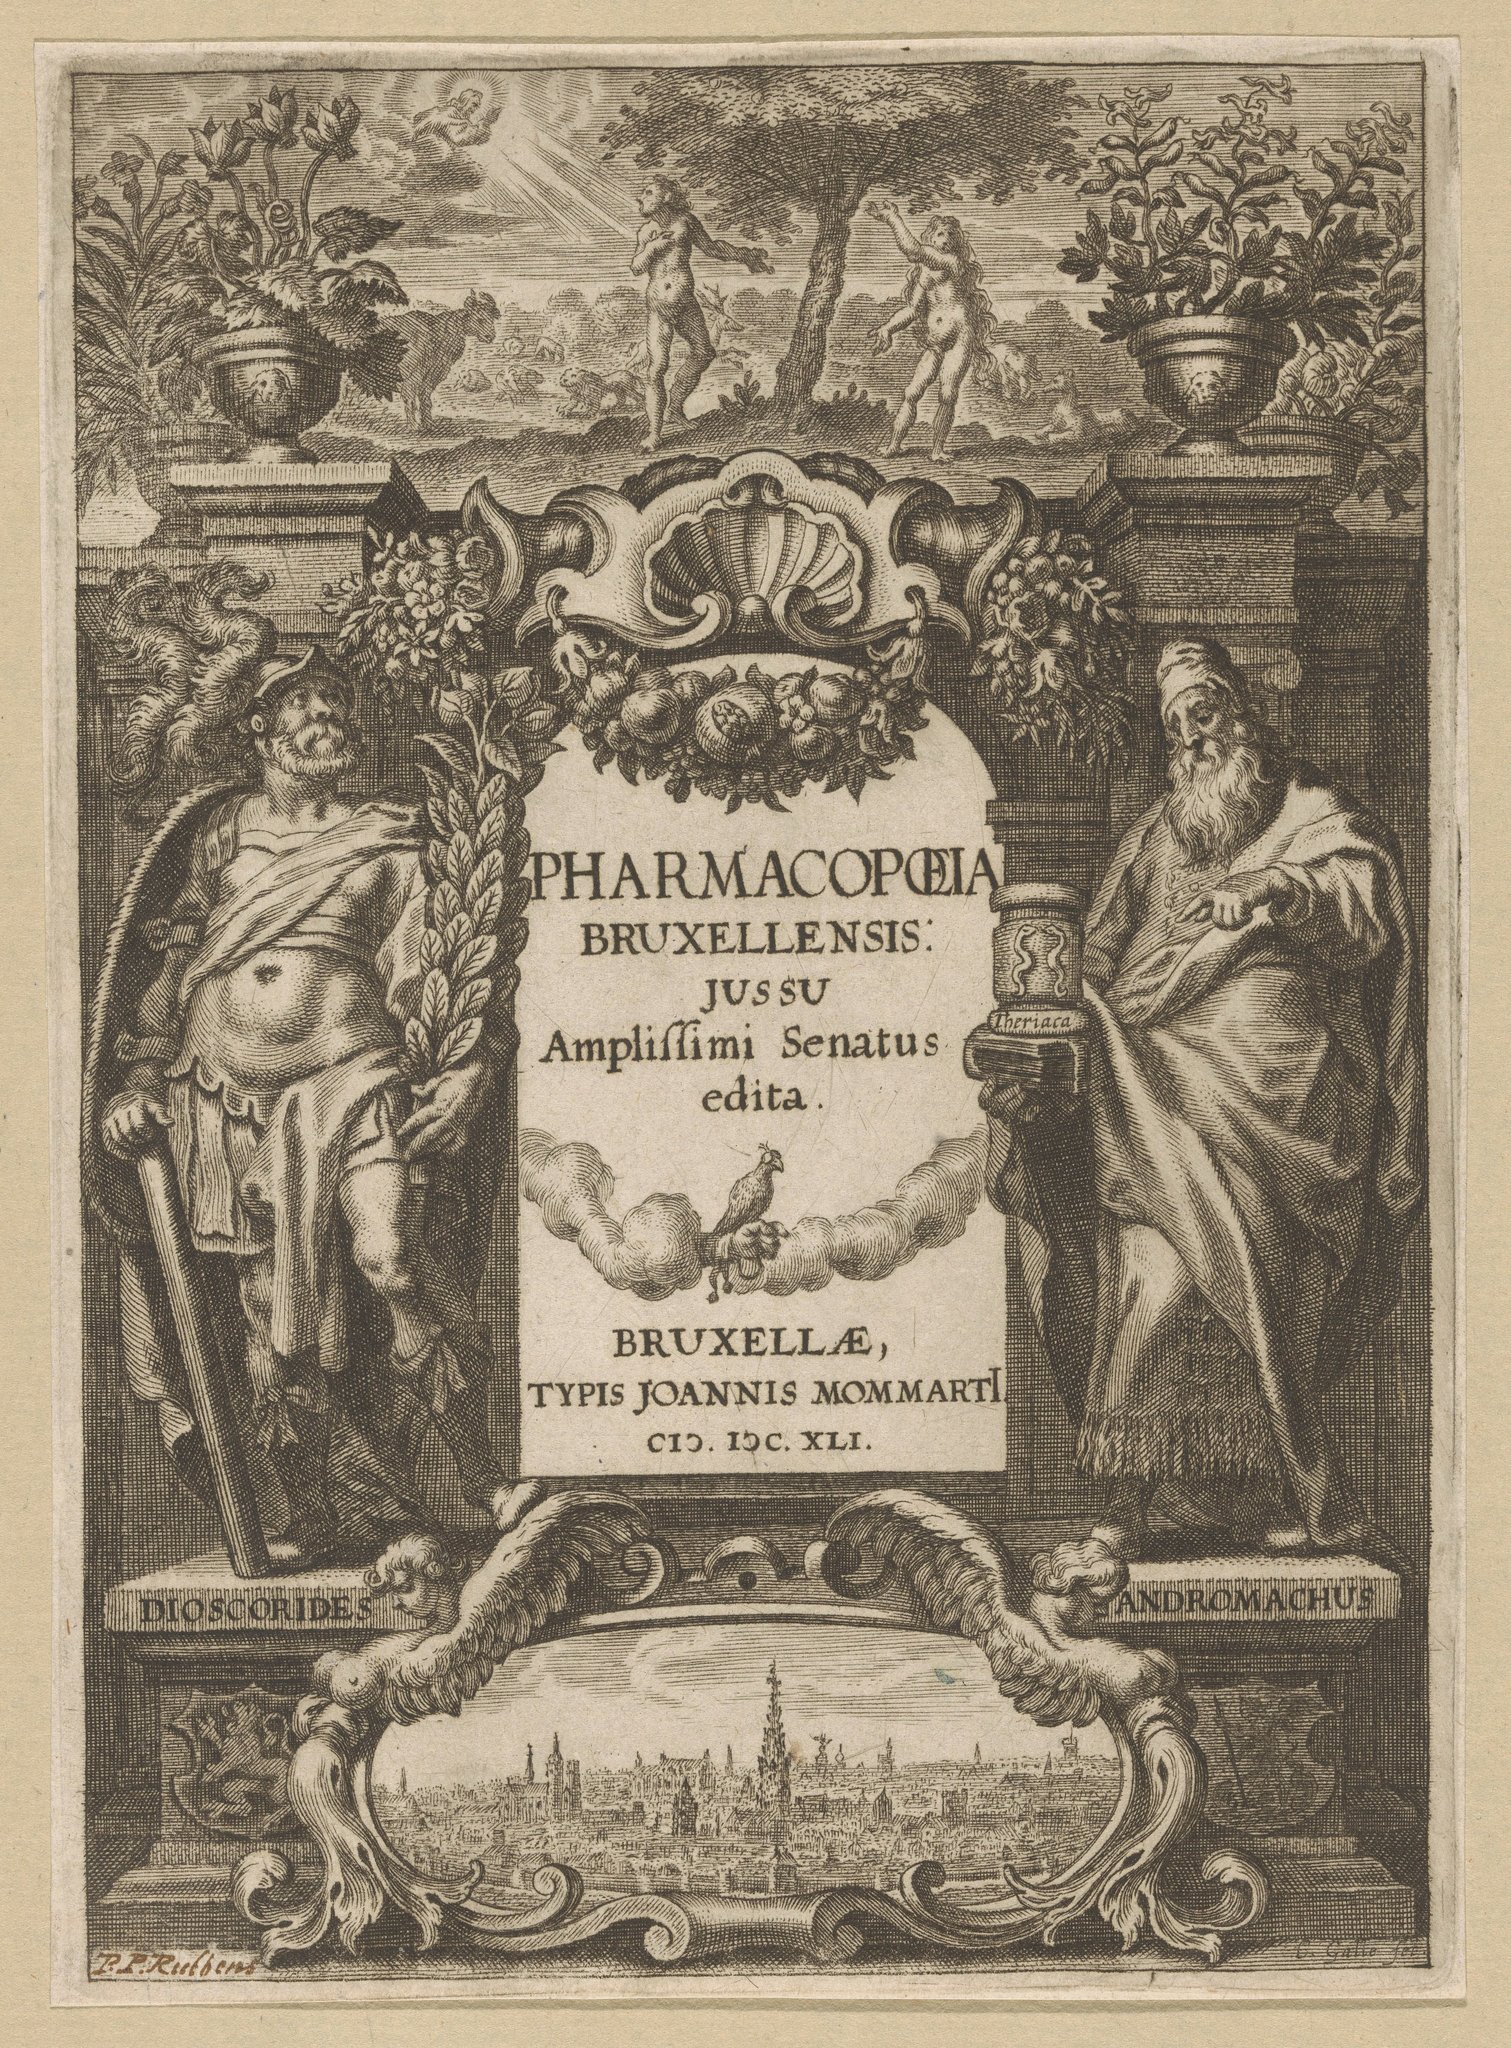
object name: titelblad, titelpagina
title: Titelpagina voor: Pharmacopoeia Bruxellensis, Brussel, 1641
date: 1641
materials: paper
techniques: engraving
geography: southern netherlands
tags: physician, doctor, adam and eve (not in biblical context), brussels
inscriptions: date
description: Titelpagina voor een farmaceutisch boek. Boven: Adam en Eva in het paradijs. In het midden de titel van het boek op een stenen tafel. Aan weerszijden twee beelden van Griekse medici: Pedanios Dioscurides en Andromachus. Onder een cartouche met een stadsgezicht op Brussel.